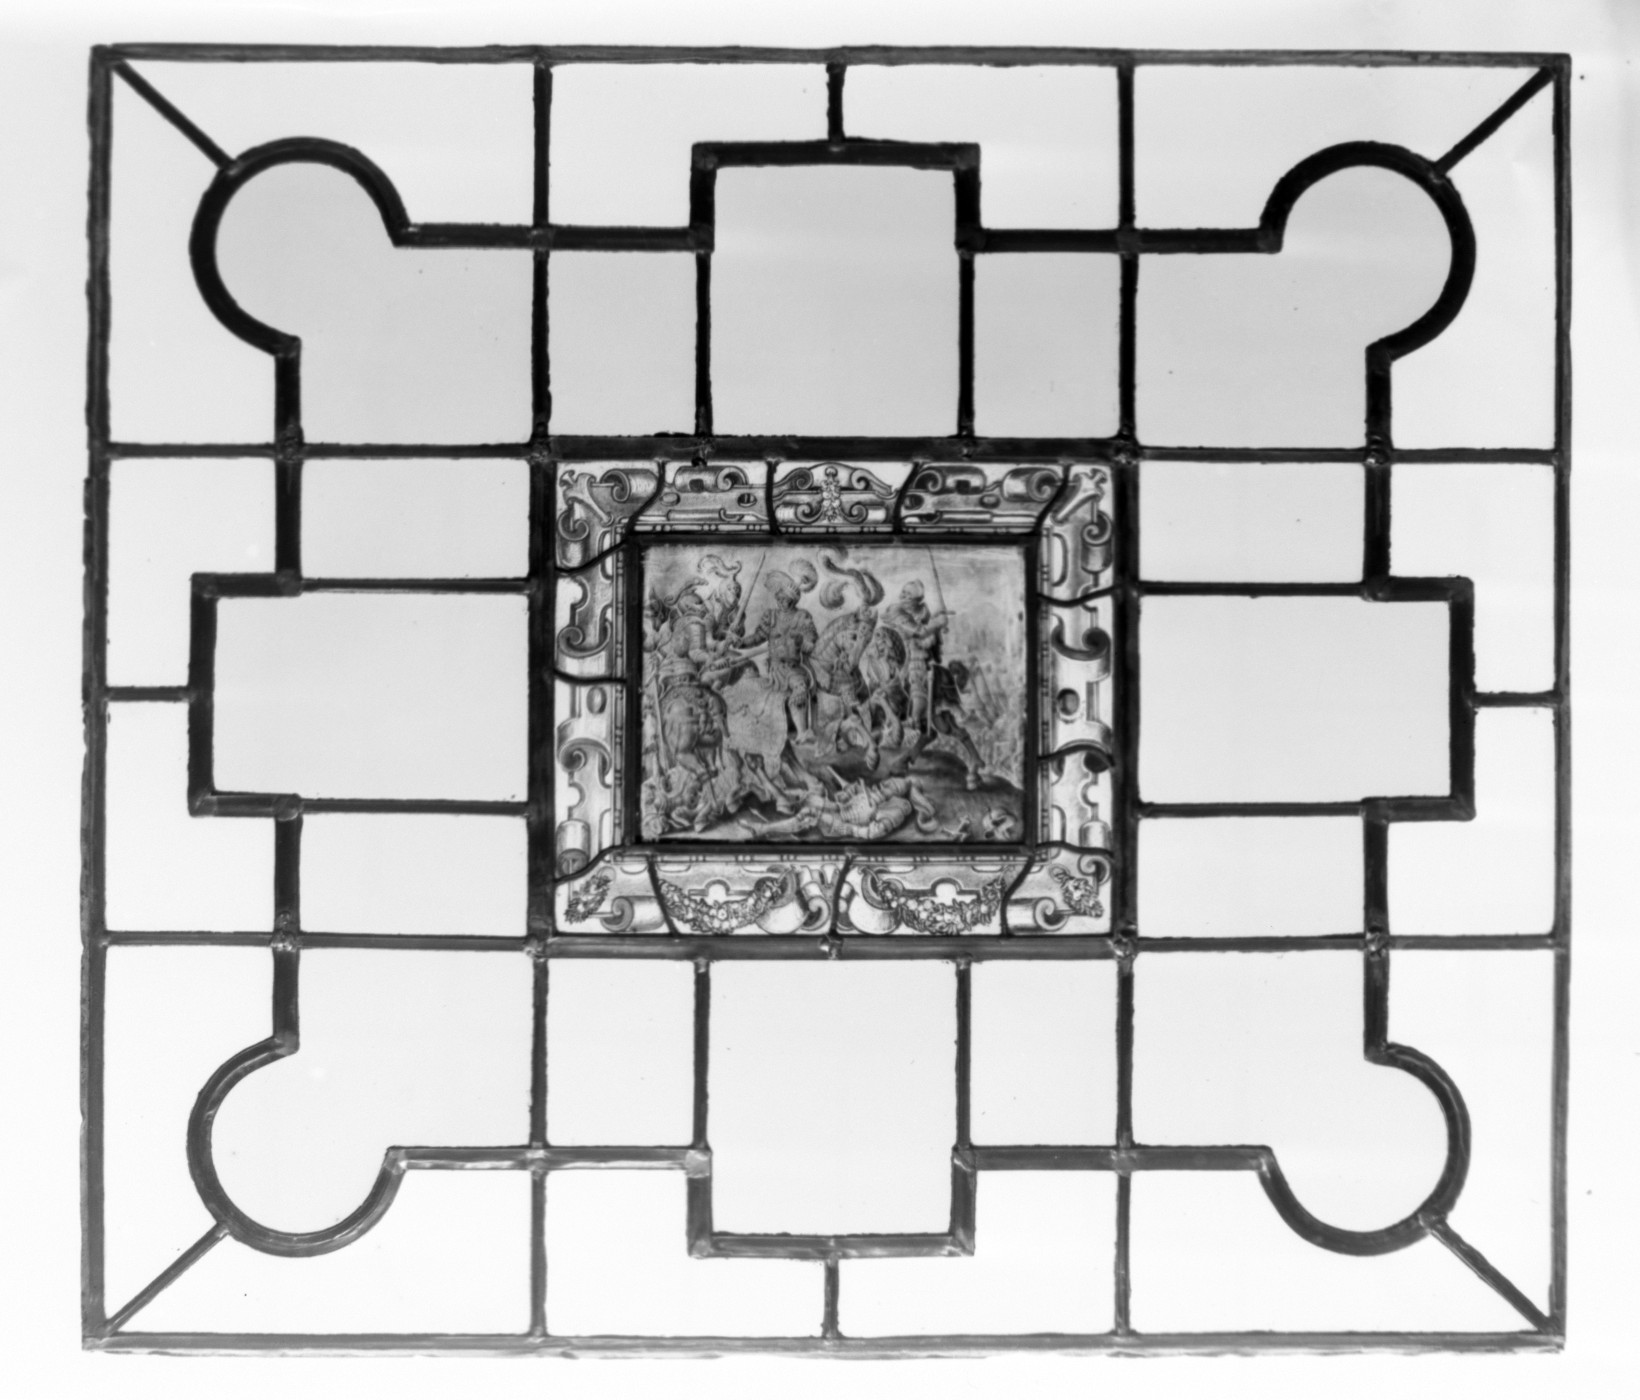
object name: panel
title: Battle scene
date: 1801-1900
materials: glass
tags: battles,soldiers